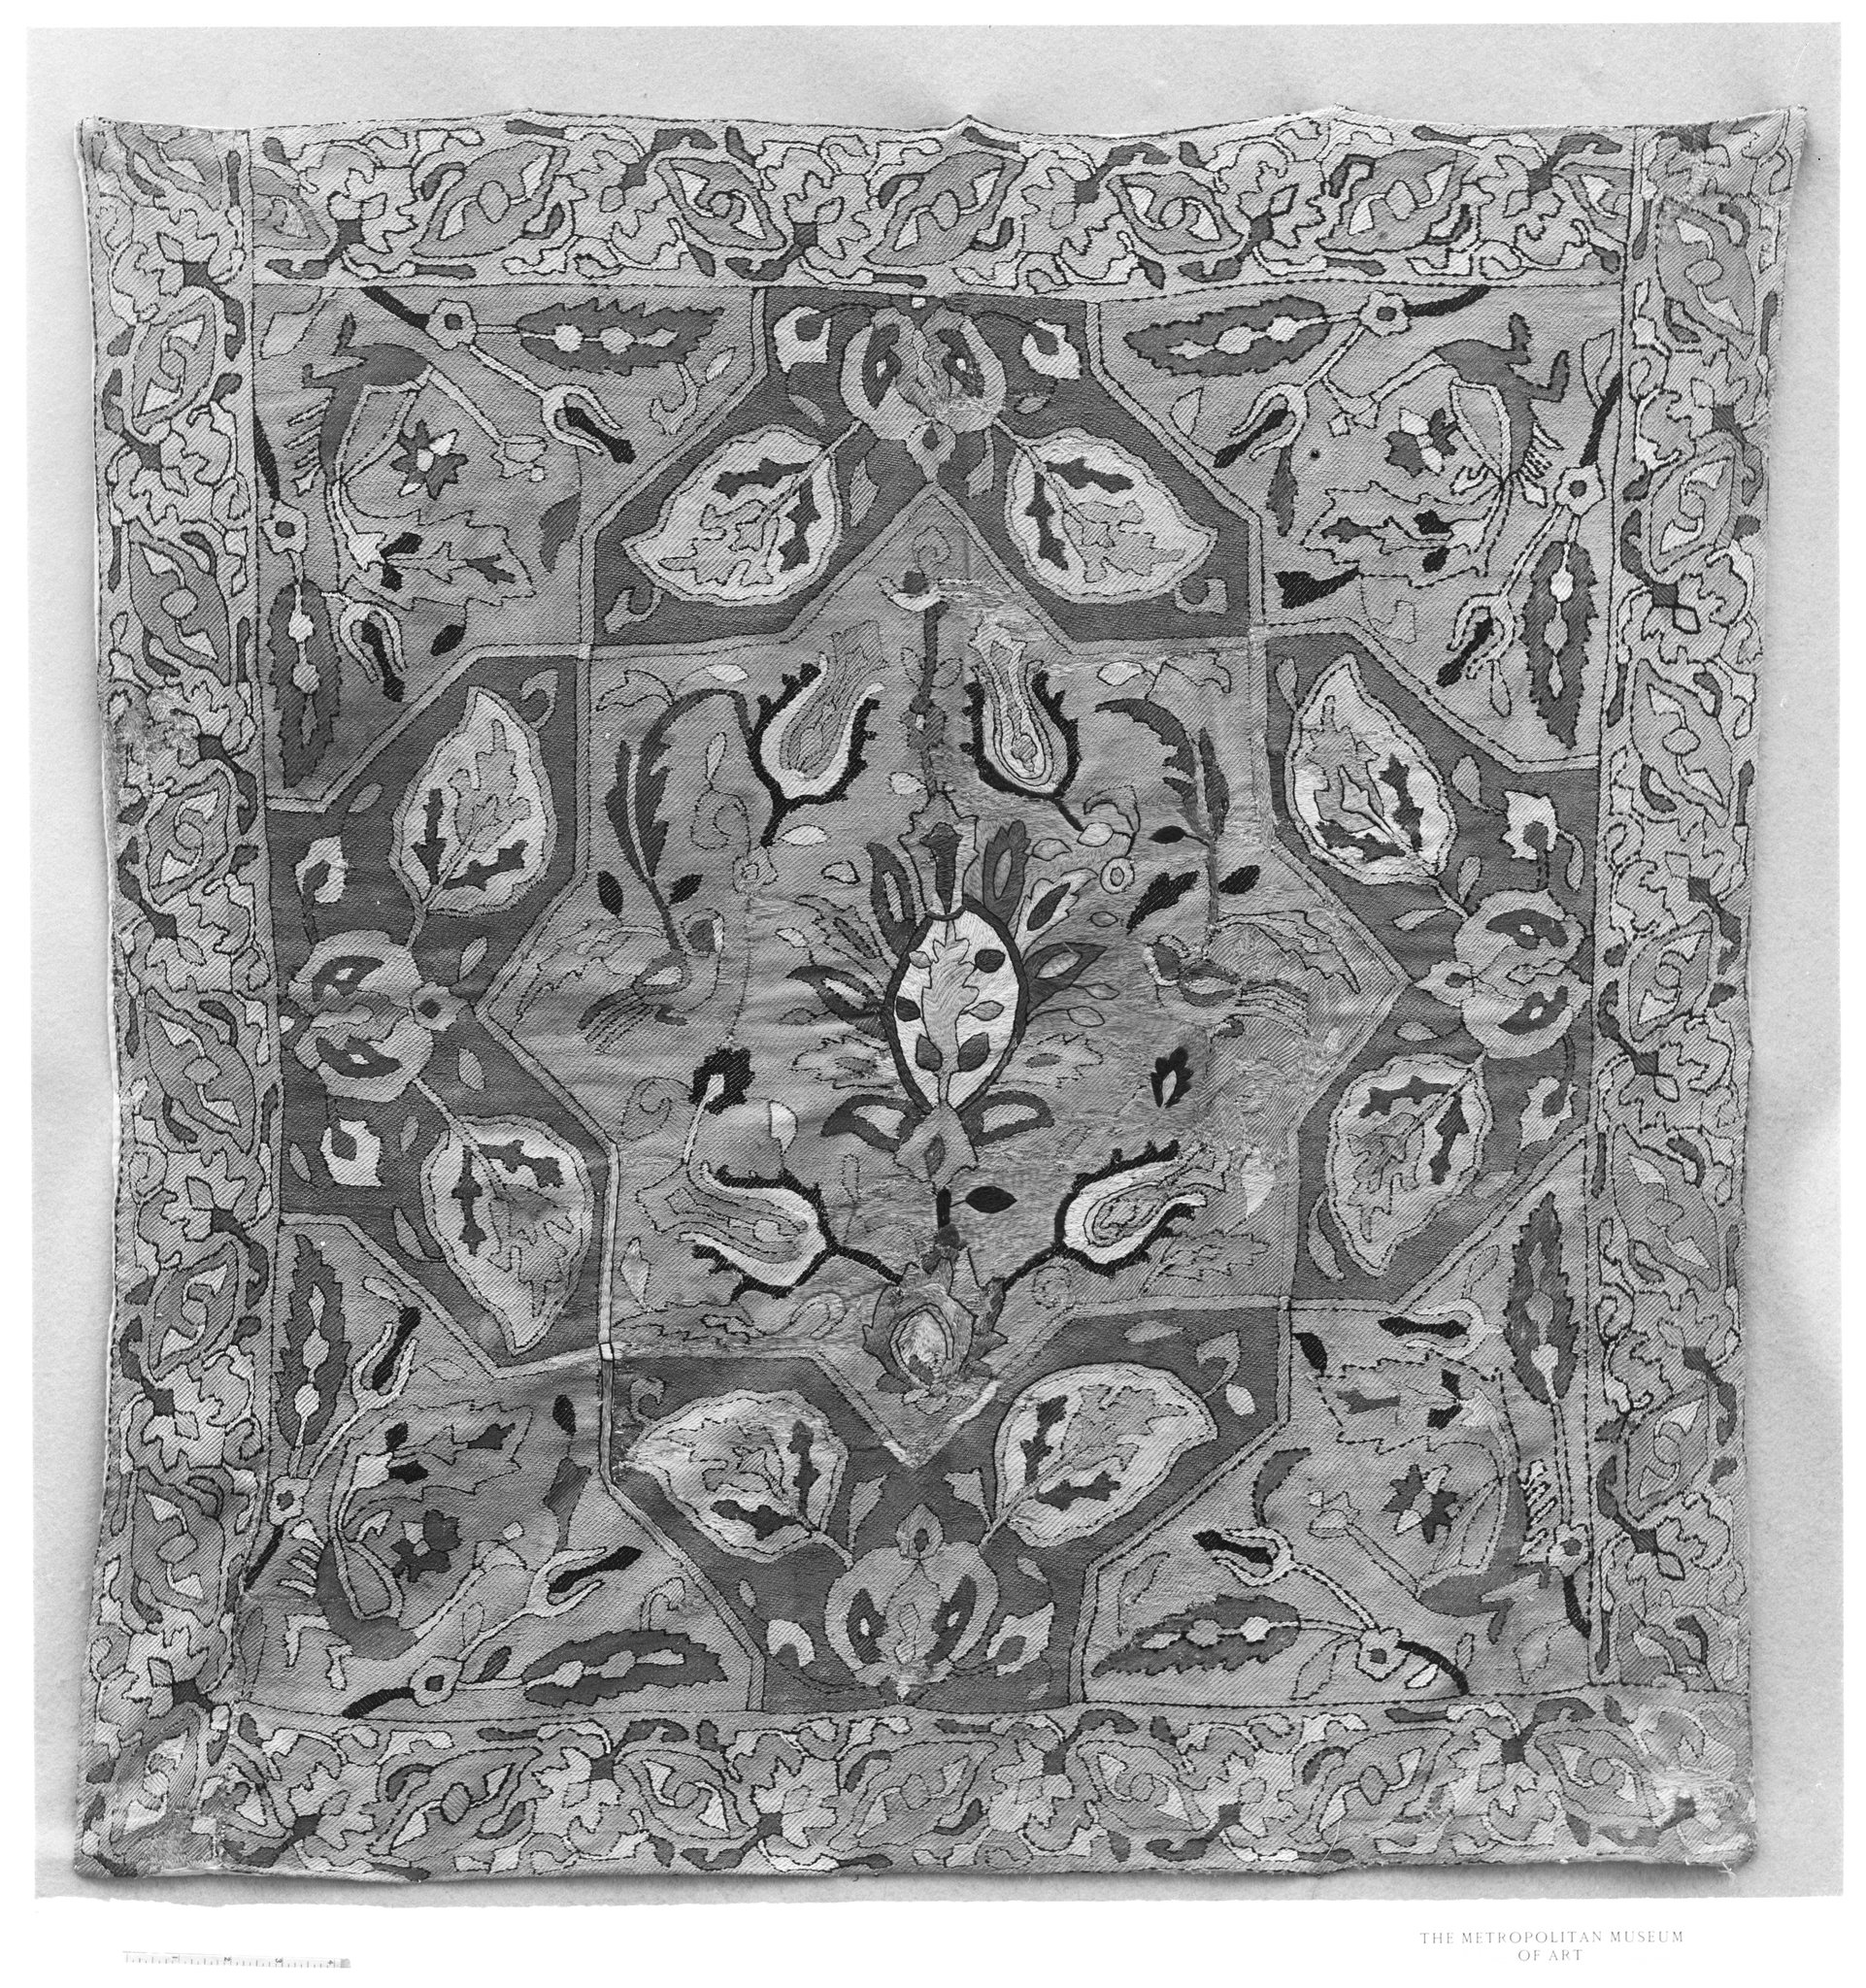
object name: cover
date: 1701-1800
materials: cotton, silk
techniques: embroidery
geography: caucasus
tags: flowers